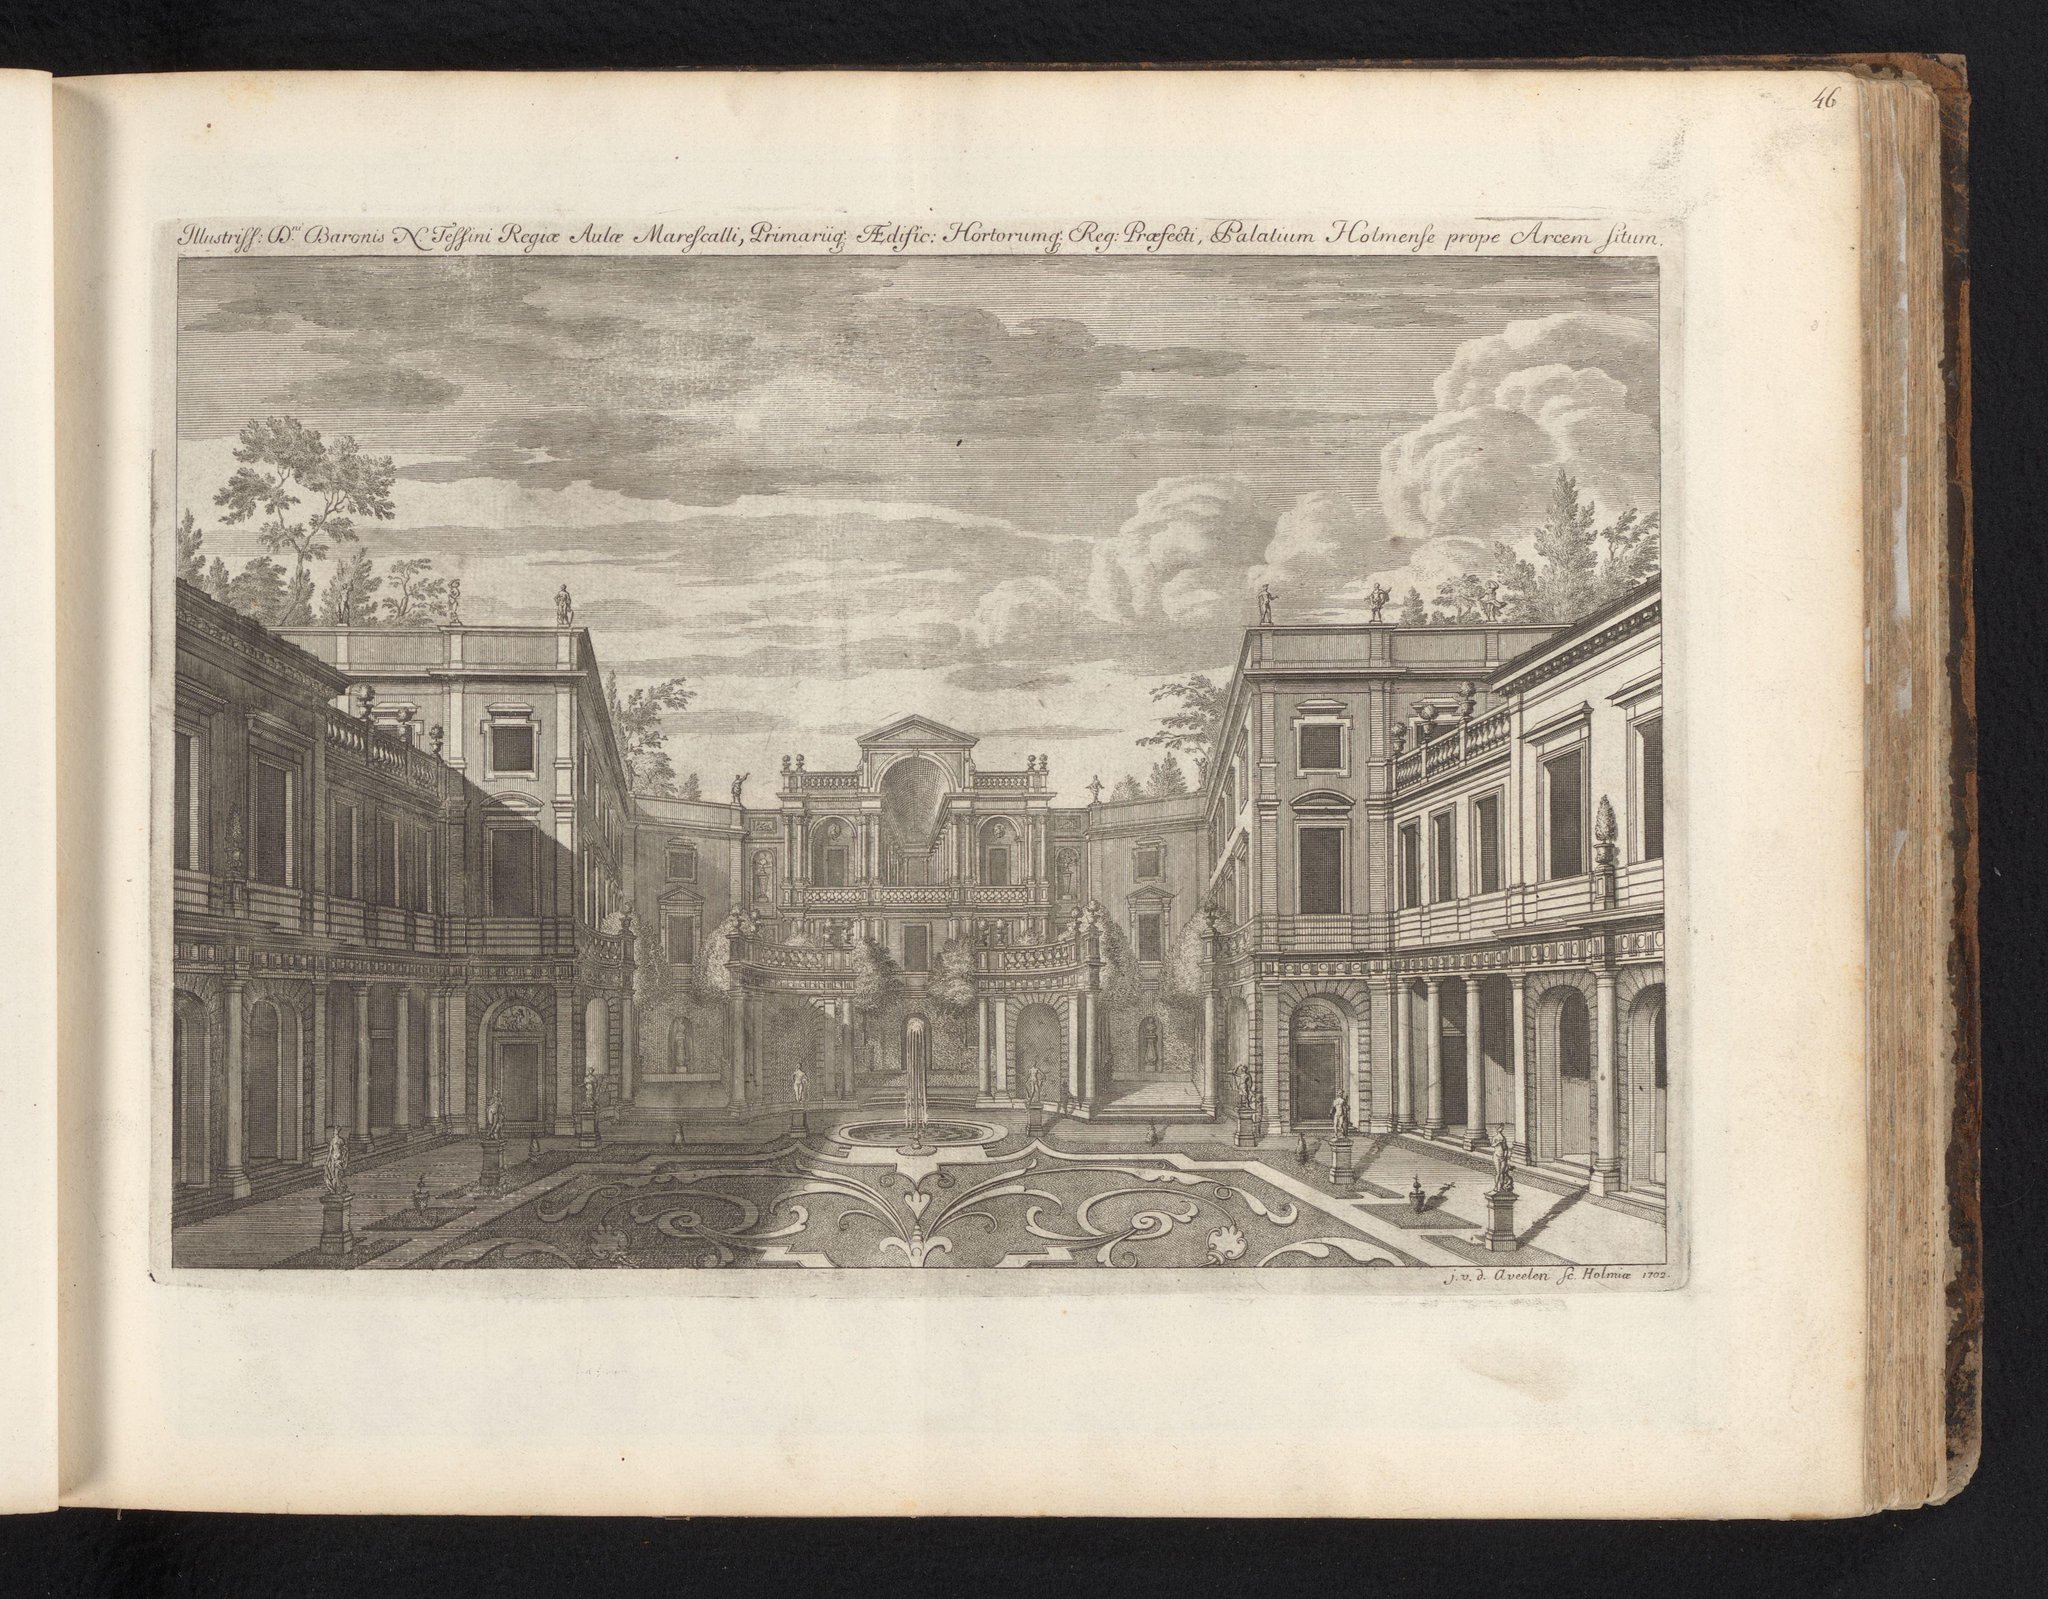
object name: album leaf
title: Suecia Antiqua et Hodierna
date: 1702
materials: paper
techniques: etching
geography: stockholm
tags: palace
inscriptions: date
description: Kungliga Biblioteket, 'Suecia': http://www.kb.se/samlingarna/Kartor-bilder/Suecia-antiqua/ (geraadpleegd november 2016).